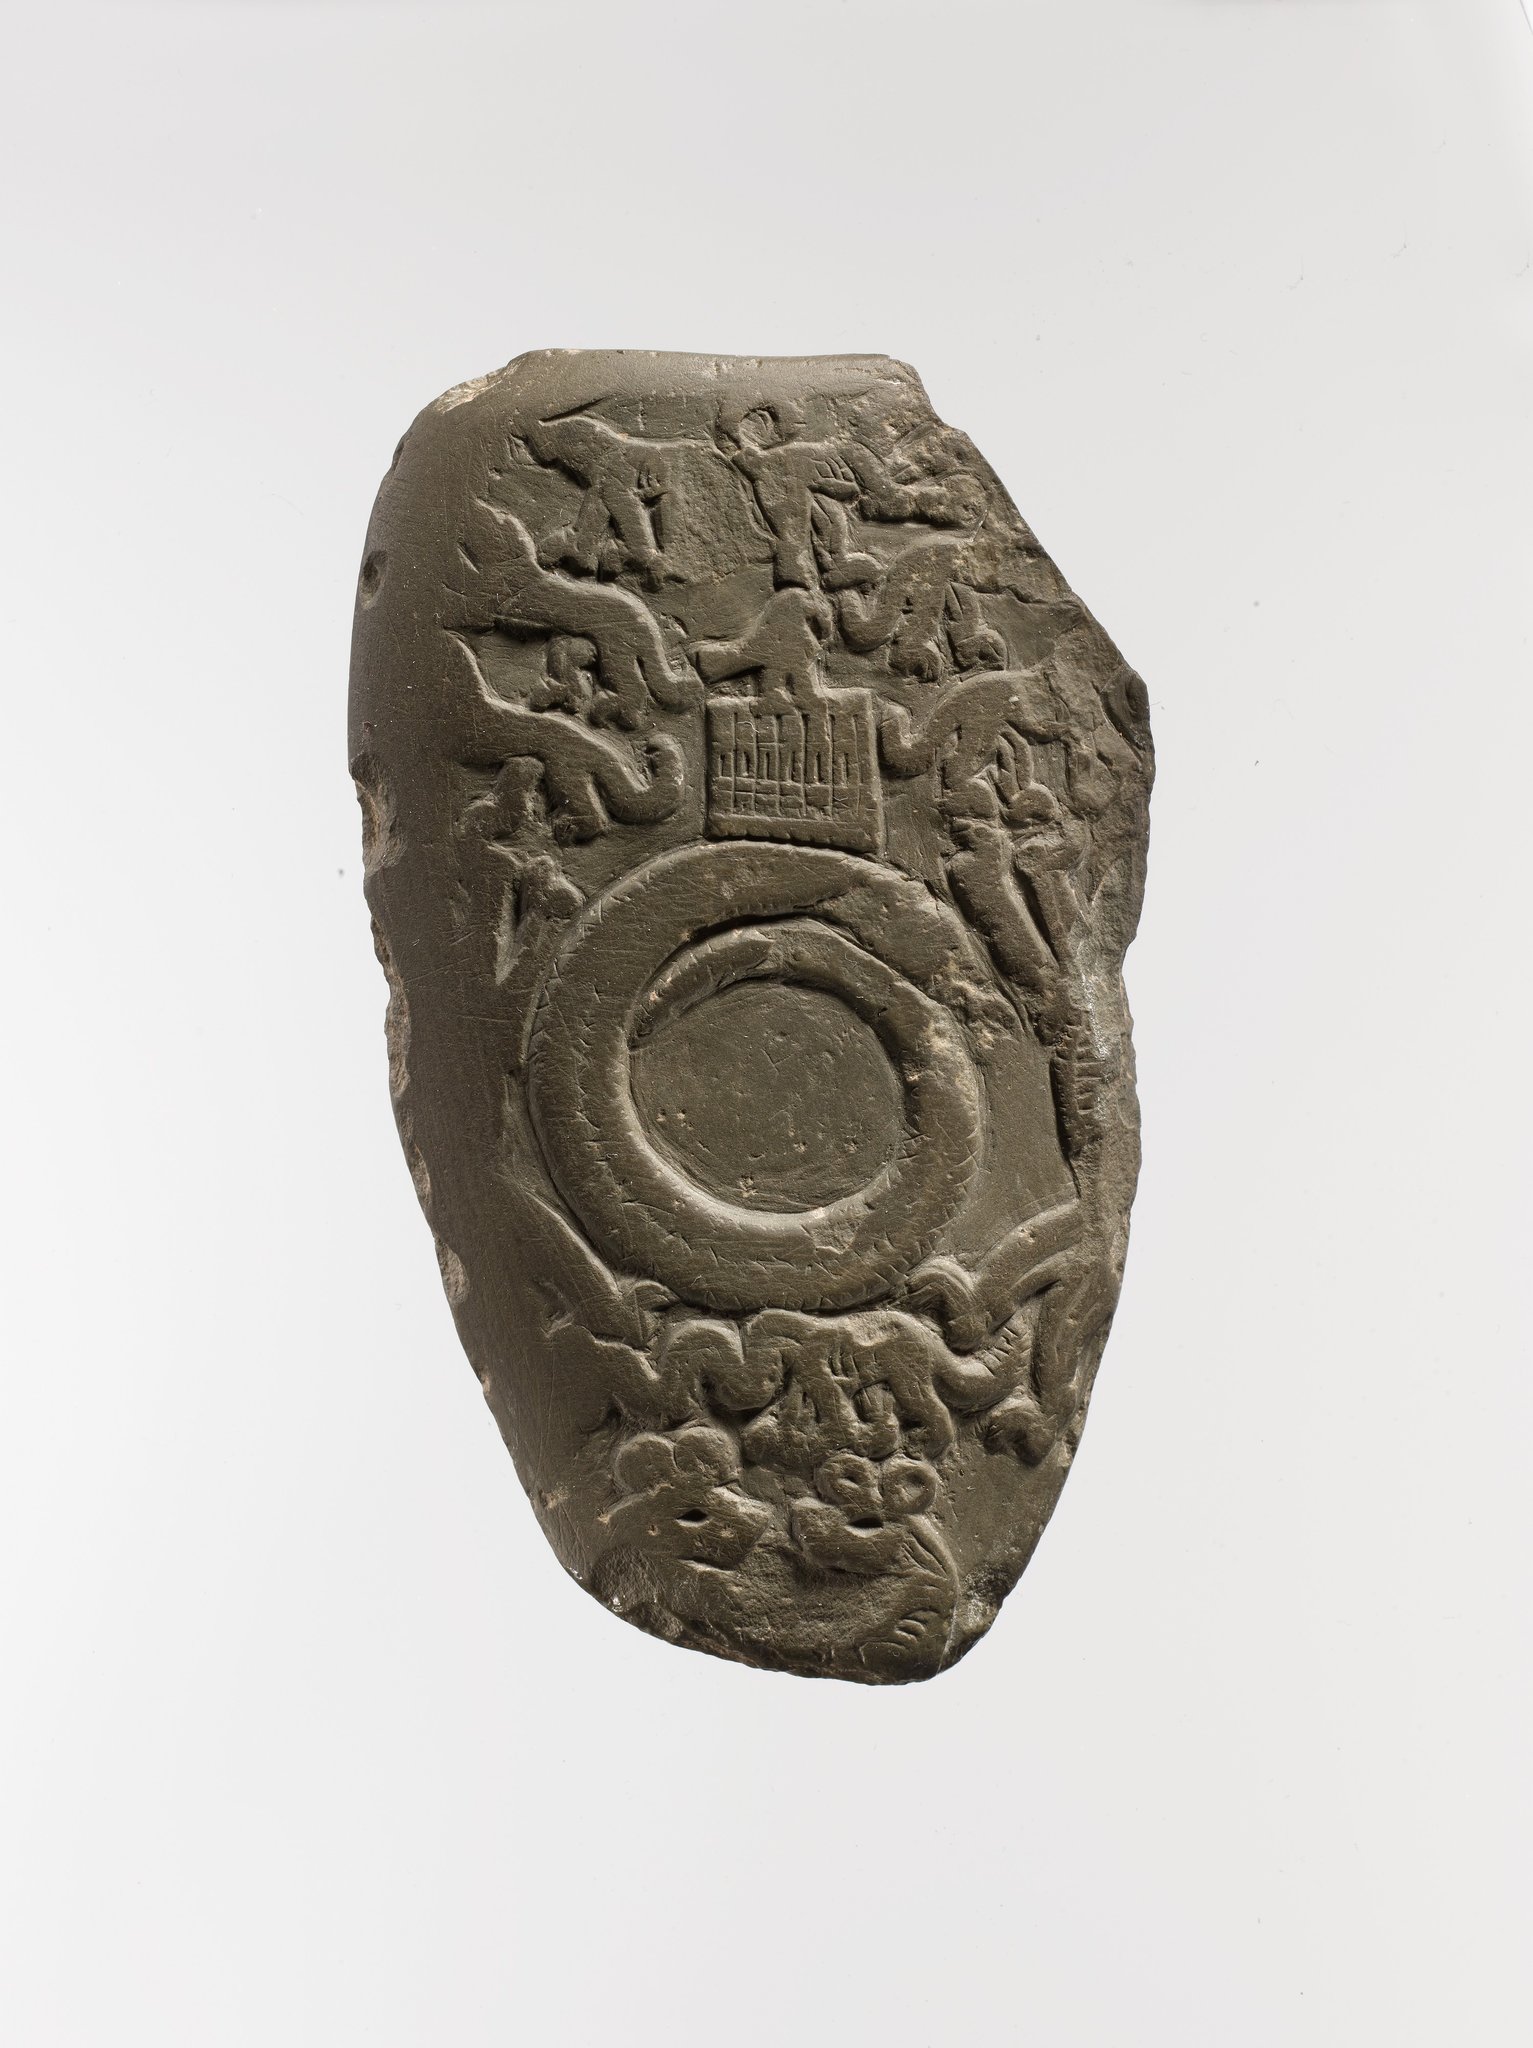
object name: palette, ceremonial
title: Carved ceremonial palette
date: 3200-3100 BCE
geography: egypt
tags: hieroglyphs